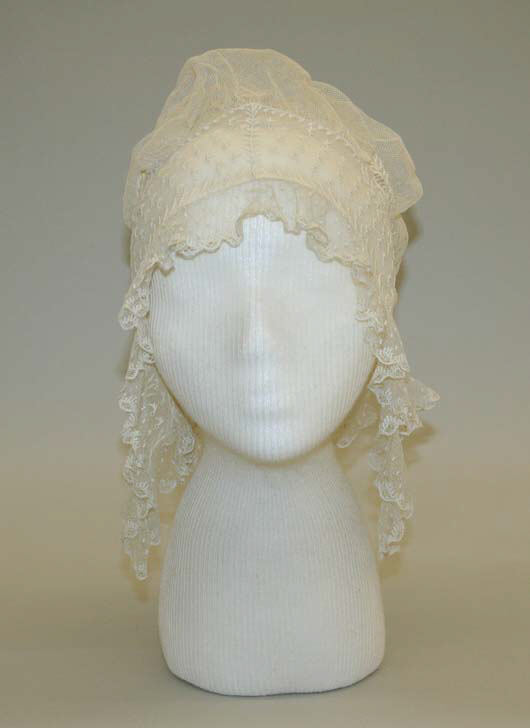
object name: cap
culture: american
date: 1815-1820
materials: cotton, linen